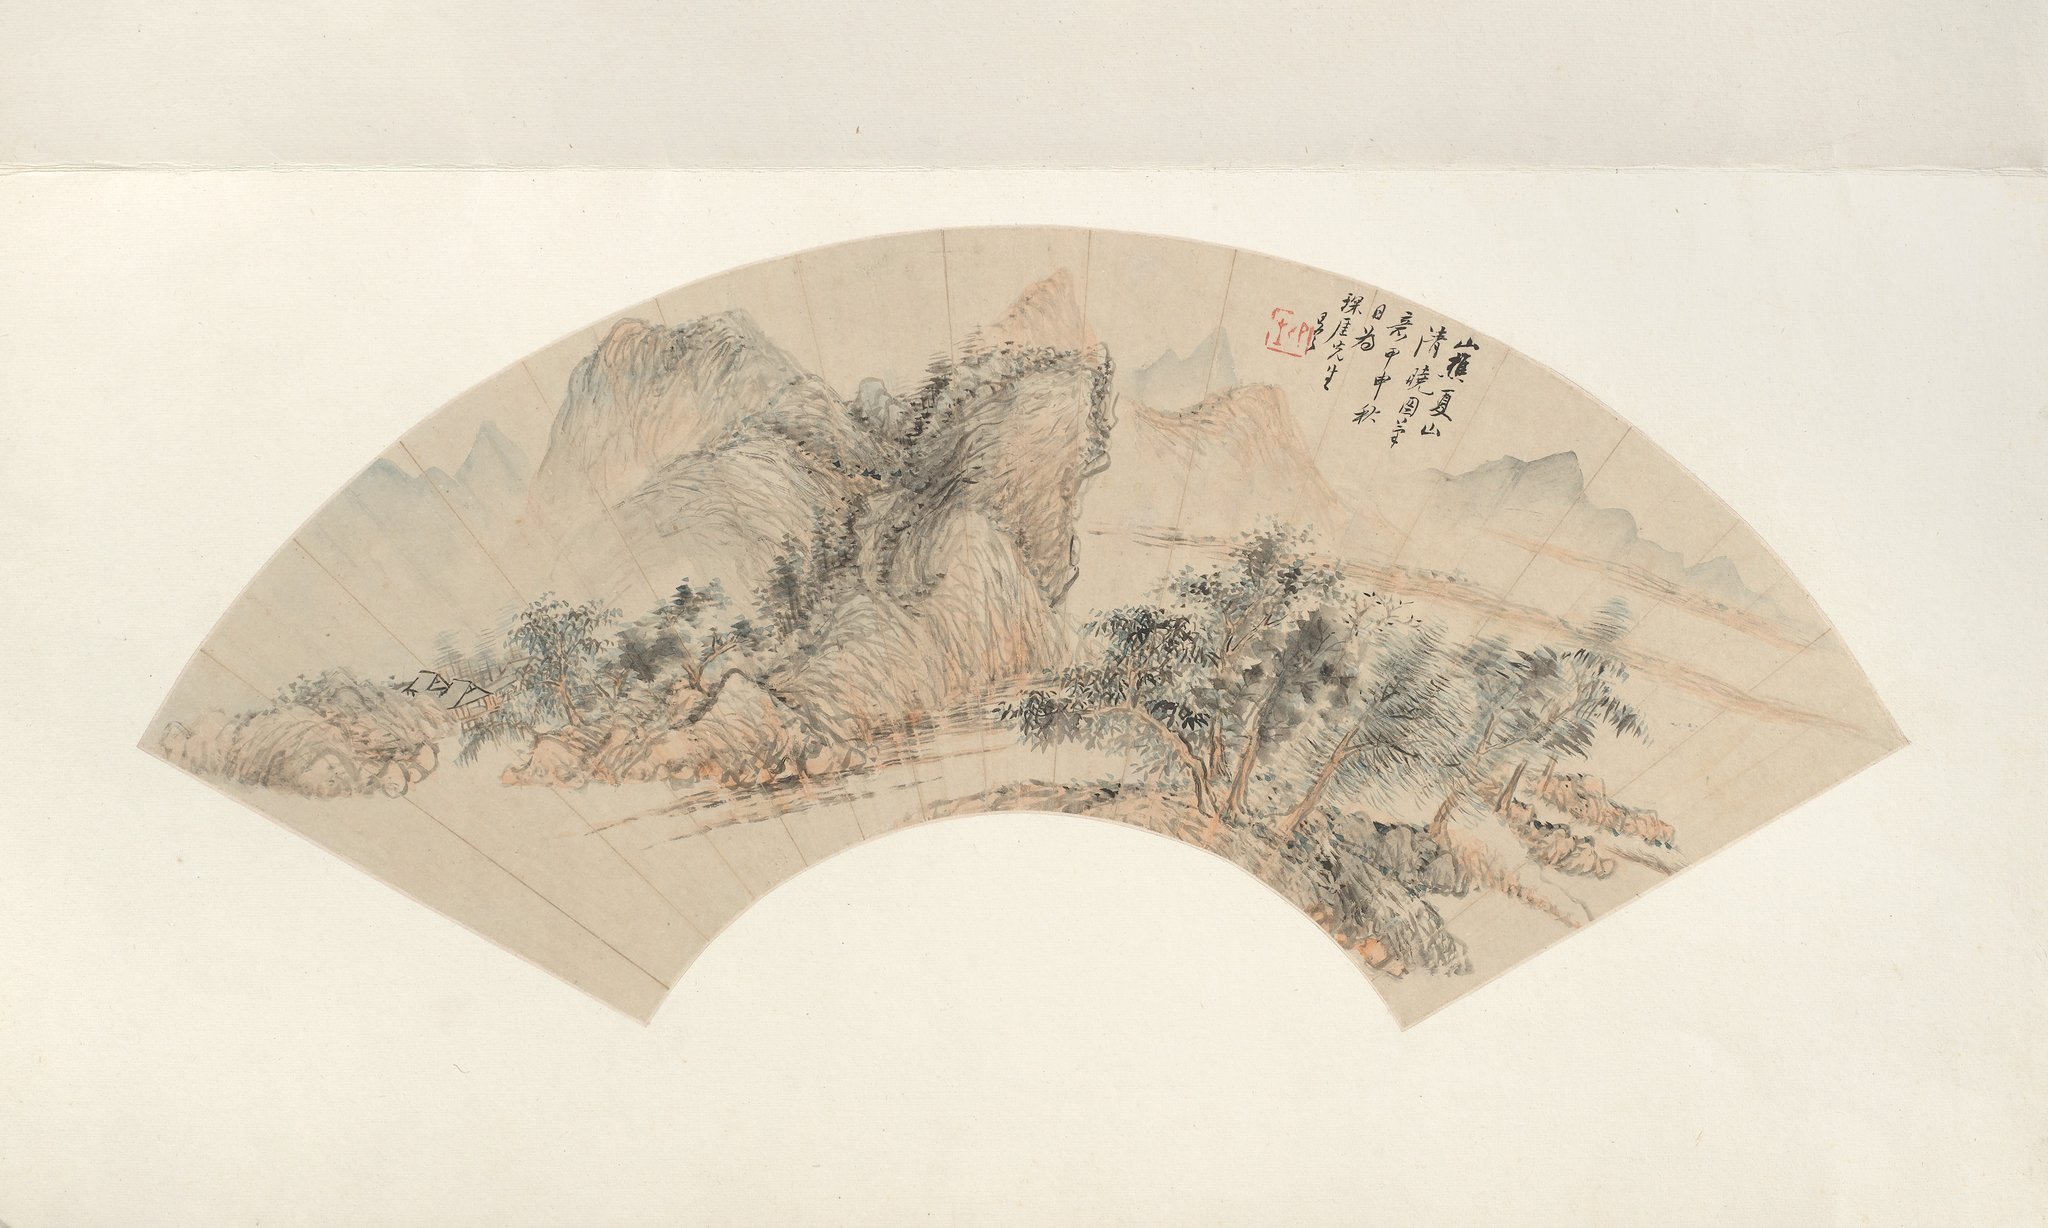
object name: fan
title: Landscape in the style of Wang Meng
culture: chinese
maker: zhu angzhi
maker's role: artist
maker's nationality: chinese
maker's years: 1764-1841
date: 1824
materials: ink, paper